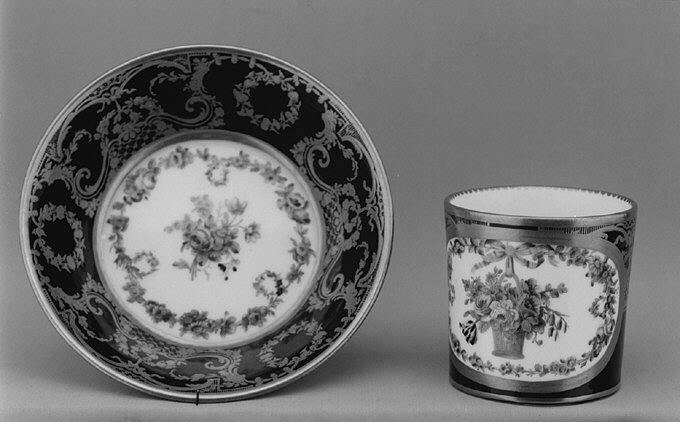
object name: cup and saucer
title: Cup and saucer (gobelet litron et soucoupe)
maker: sèvres manufactory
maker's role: manufactory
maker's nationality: french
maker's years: 1740-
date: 1776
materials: soft paste porcelain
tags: flowers